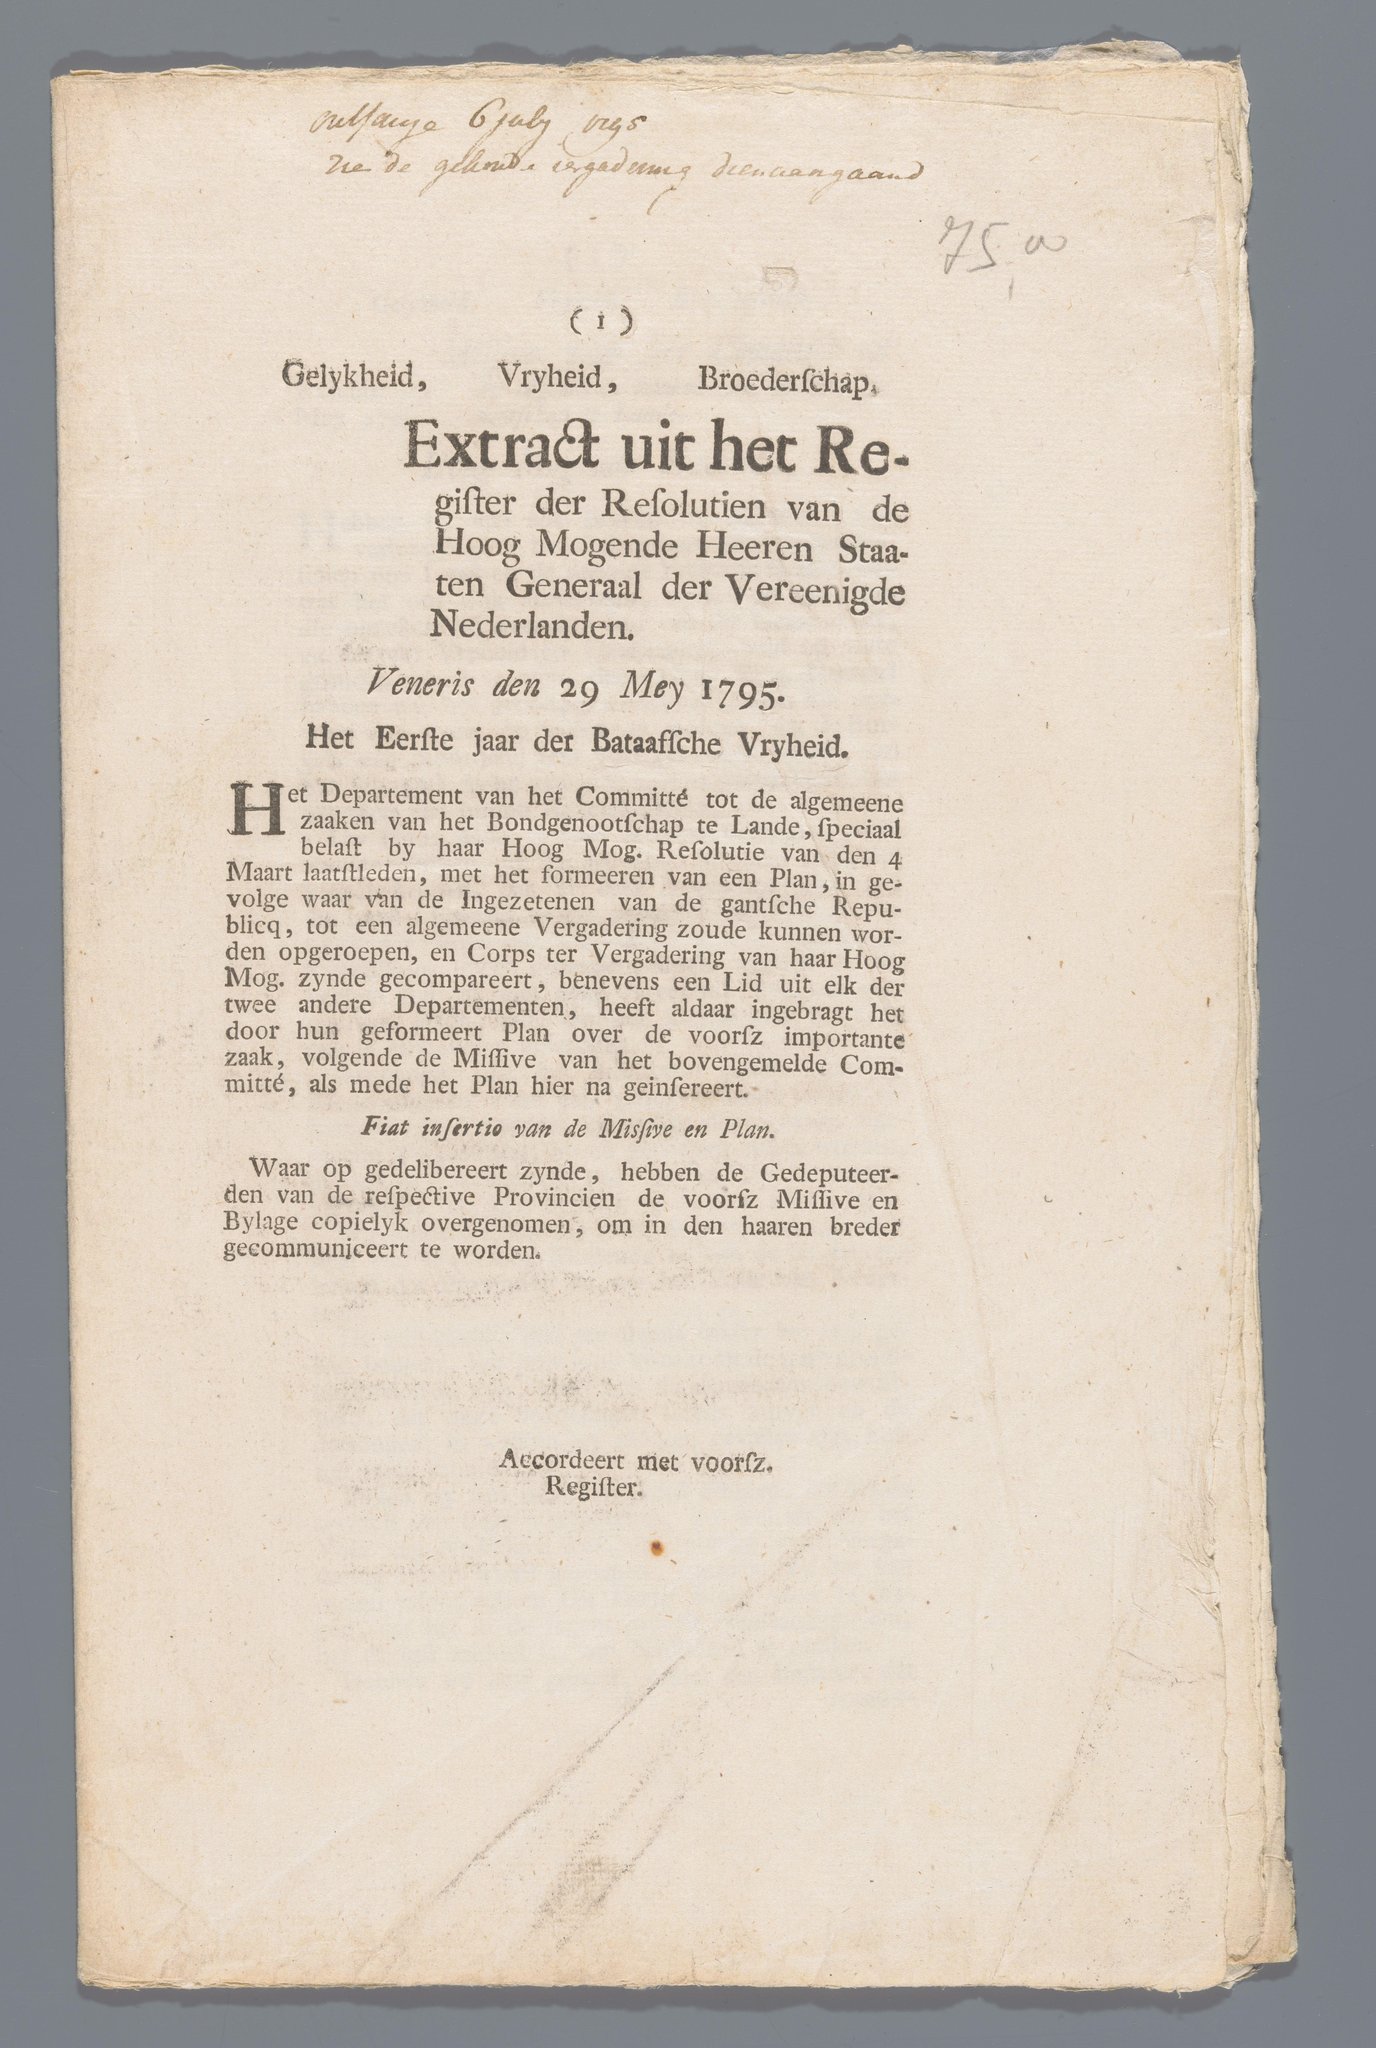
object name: pamphlet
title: Extract uit het Register der Resolutien van de Hoog Mogende Heeren Staaten Generaal der Vereenigde Nederlanden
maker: Anonymous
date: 1795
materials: paper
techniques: letterpress printing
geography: the hague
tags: low countries